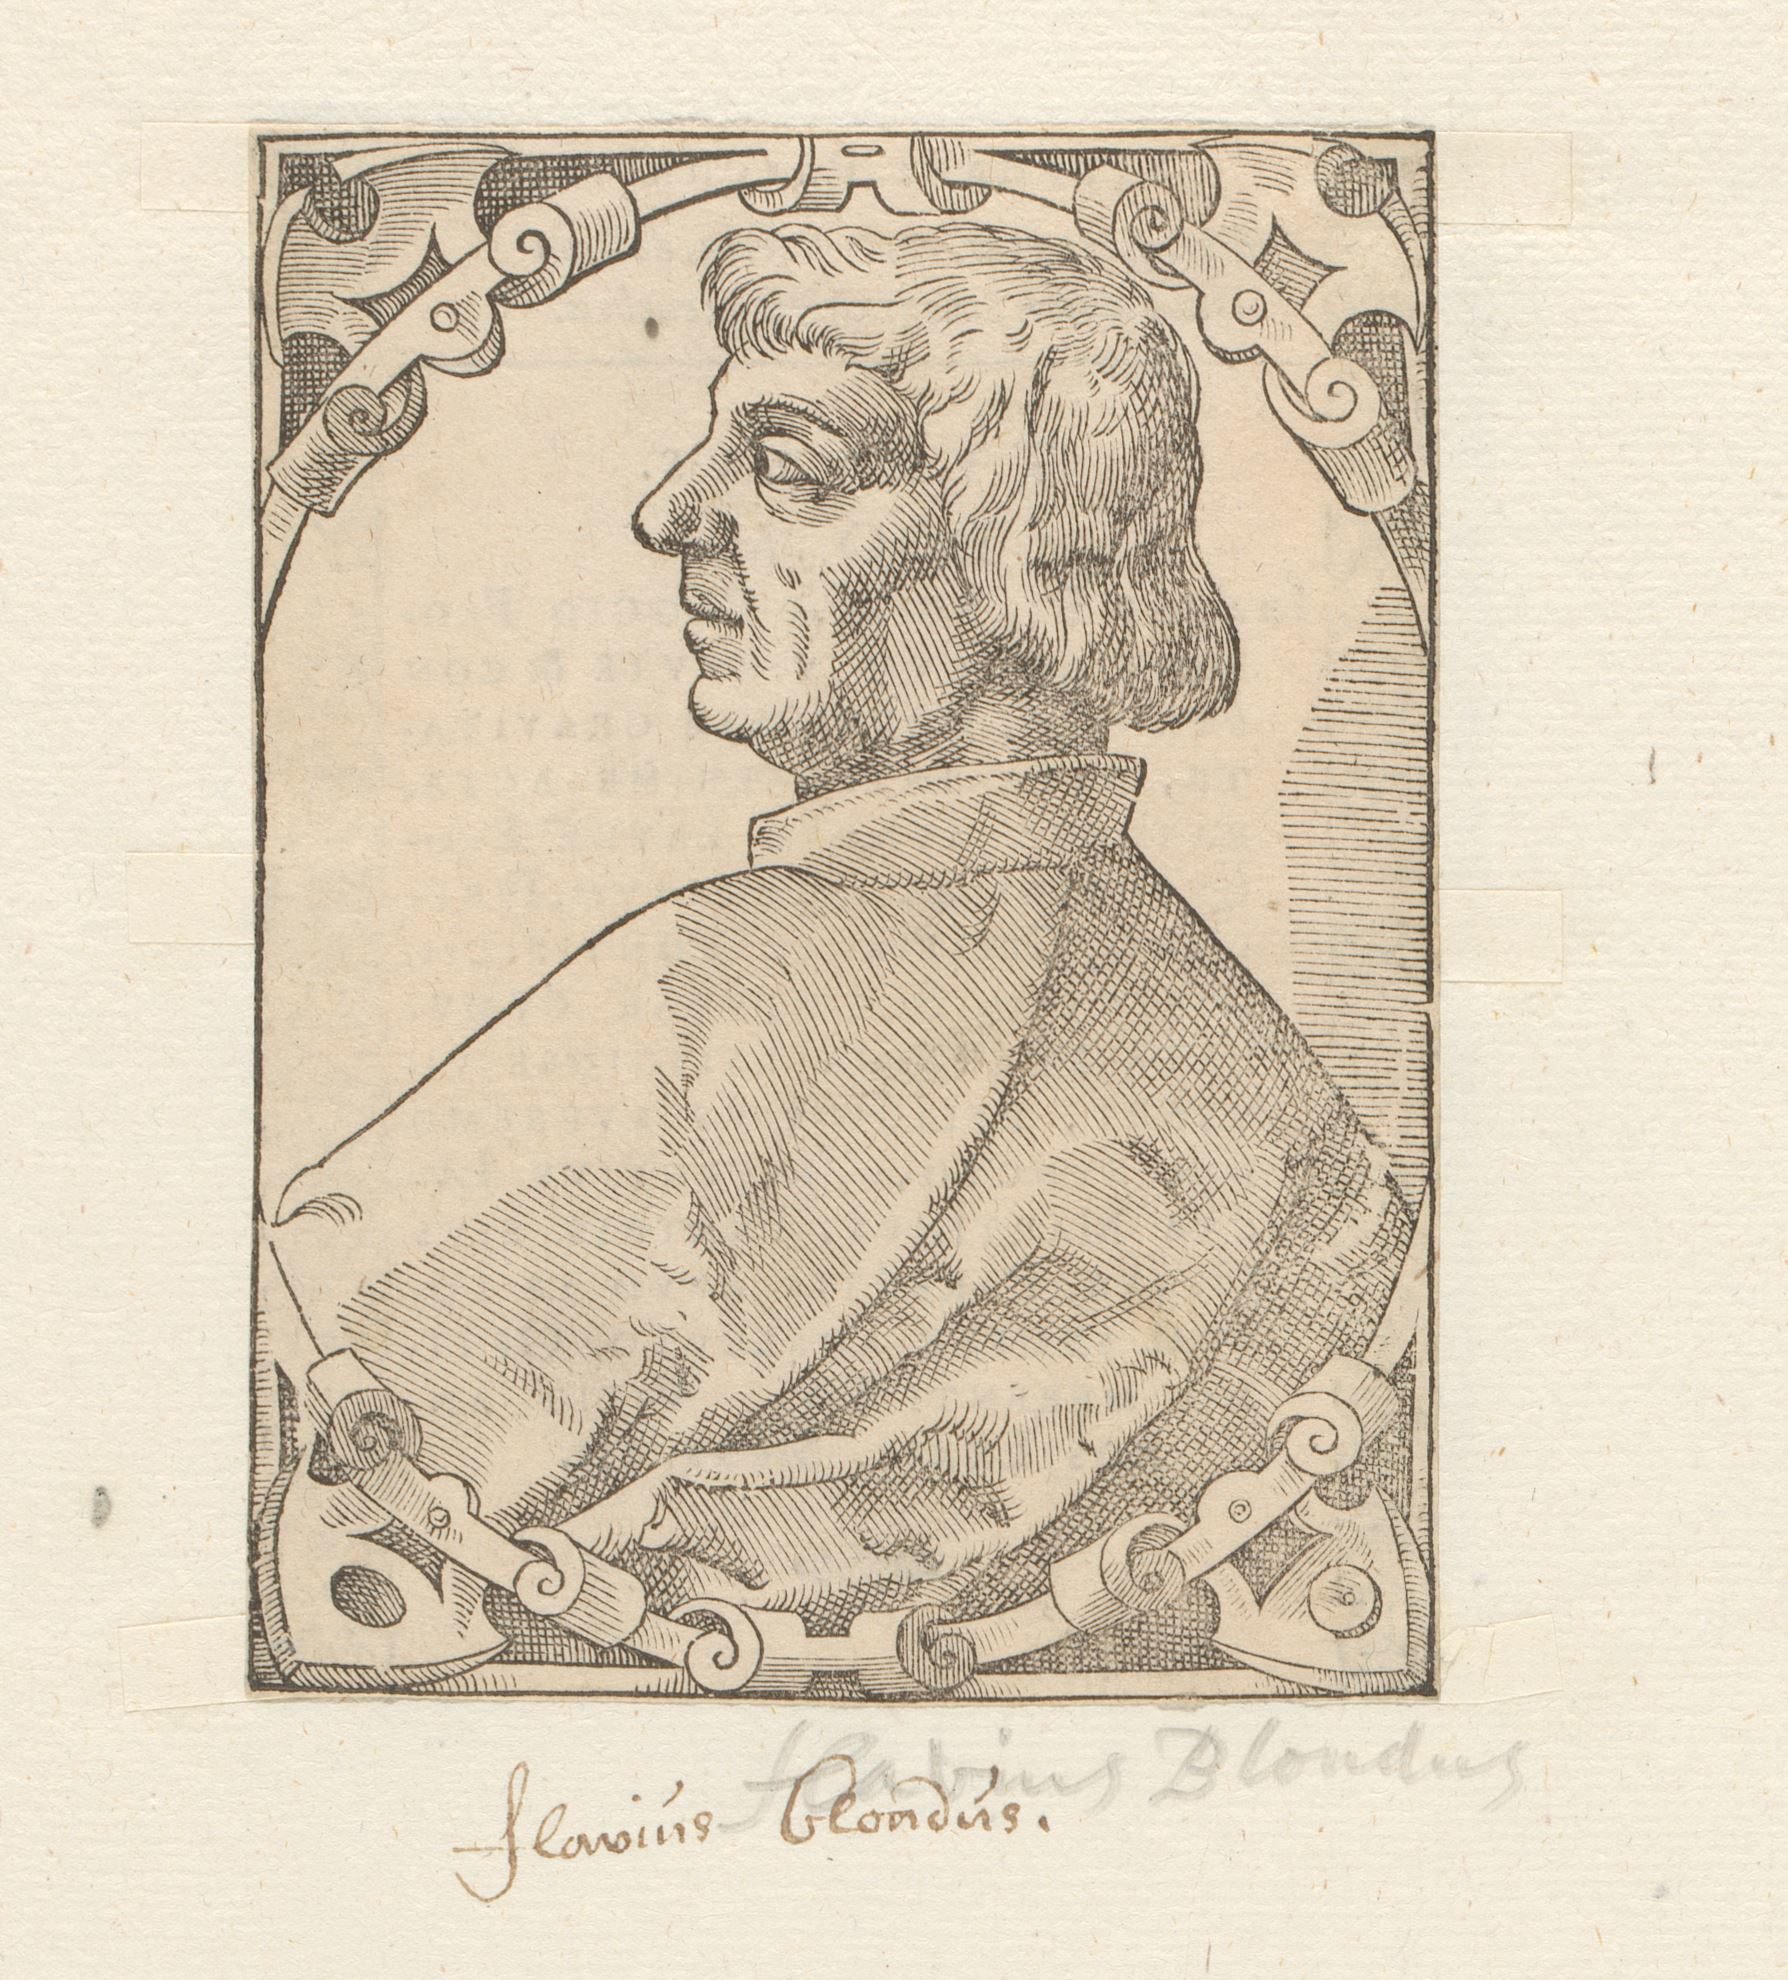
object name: book illustration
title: Portret van Flavio Biondo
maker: Anonymous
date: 1549-1577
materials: paper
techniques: letterpress printing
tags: history and archaeology (+ portrait of scholar, scientist), historical persons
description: Prent gebruikt in: Giovio, Paolo. Elogia Virorum literis illustrium (...). Bazel: Peter Perna, 1577.